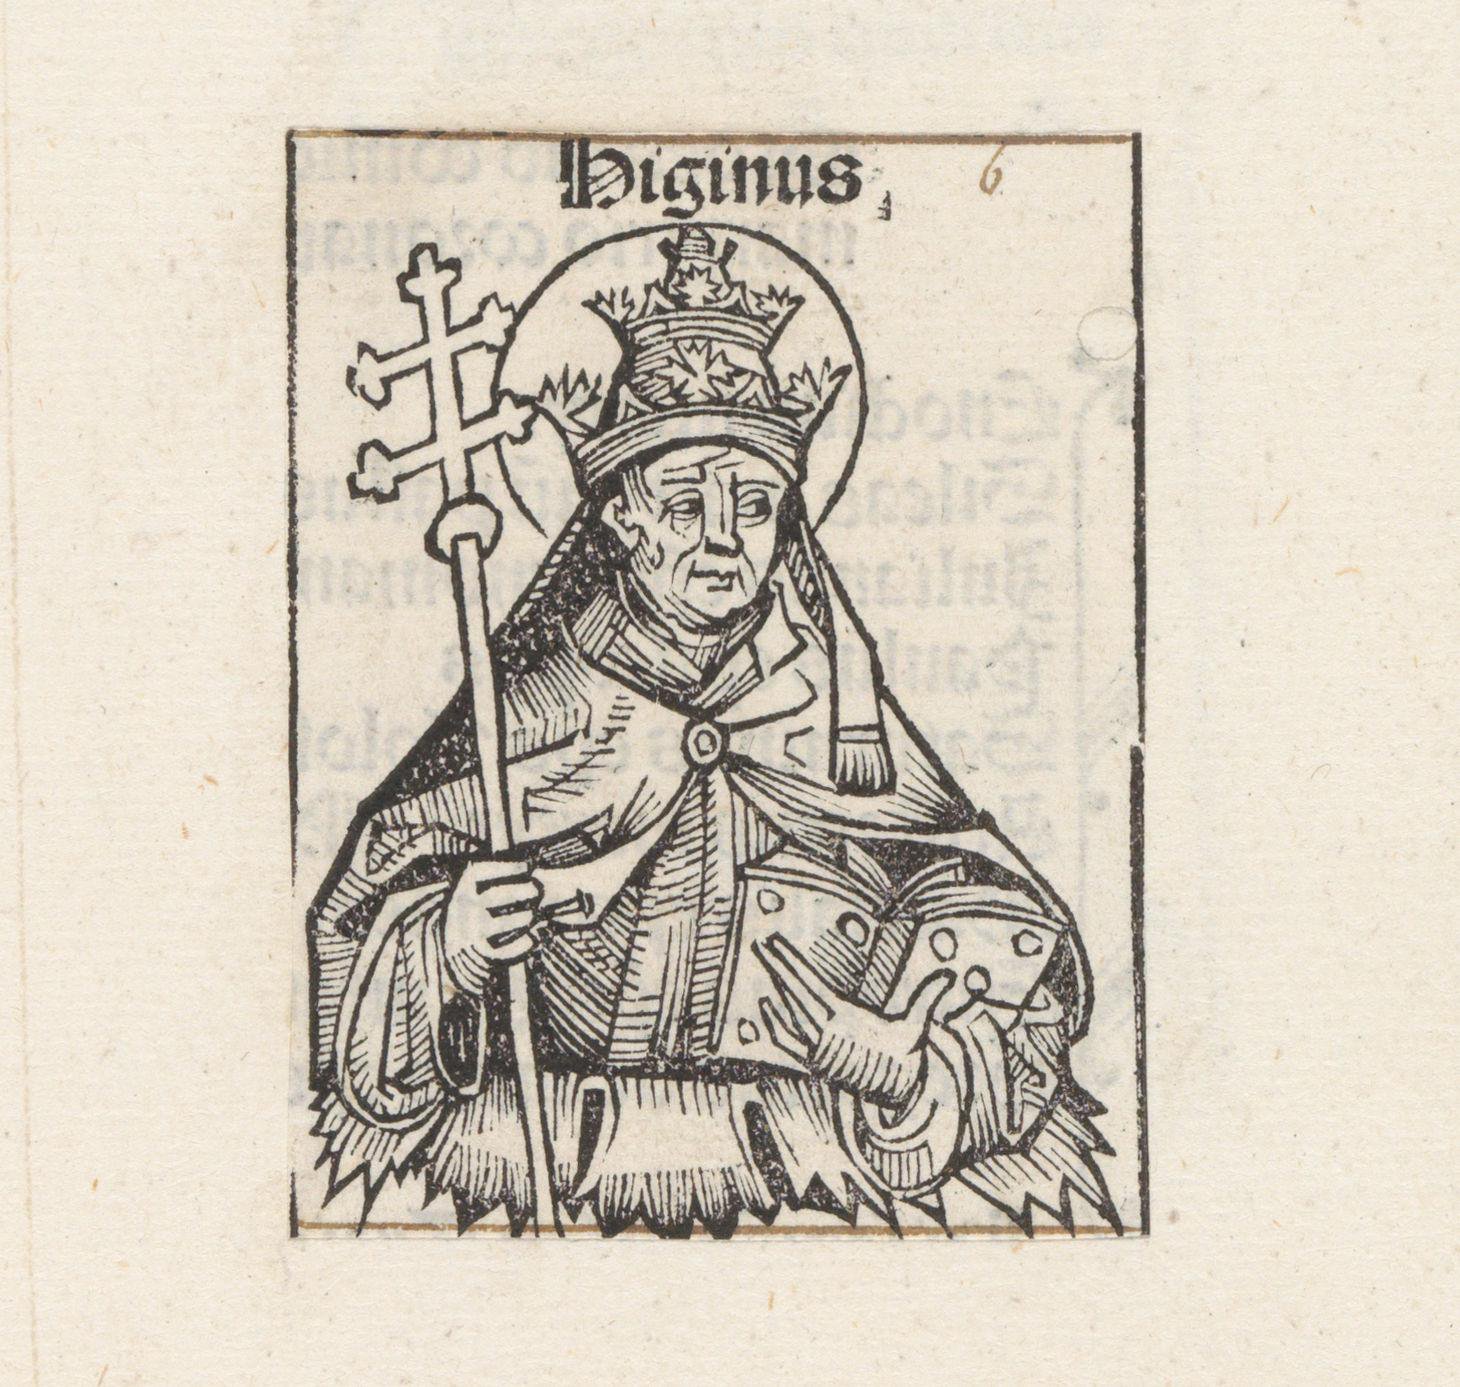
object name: album leaf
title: Higinus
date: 1493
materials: paper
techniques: letterpress printing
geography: nuremberg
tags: rome, pope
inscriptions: inscription: ‘6’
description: Een bloemkelk met een paus. Hij draagt een tiara en heeft een opengeslagen bijbel en staf met een dubbel kruis in zijn handen. De nimbus om zijn hoofd vertelt dat deze paus heilig is verklaard. De voorstelling is onderdeel van de opeenvolging pausen in de Liber Chronicarum. De tekst identificeert de man als paus Hyginus. De prent maakt deel uit van een album.